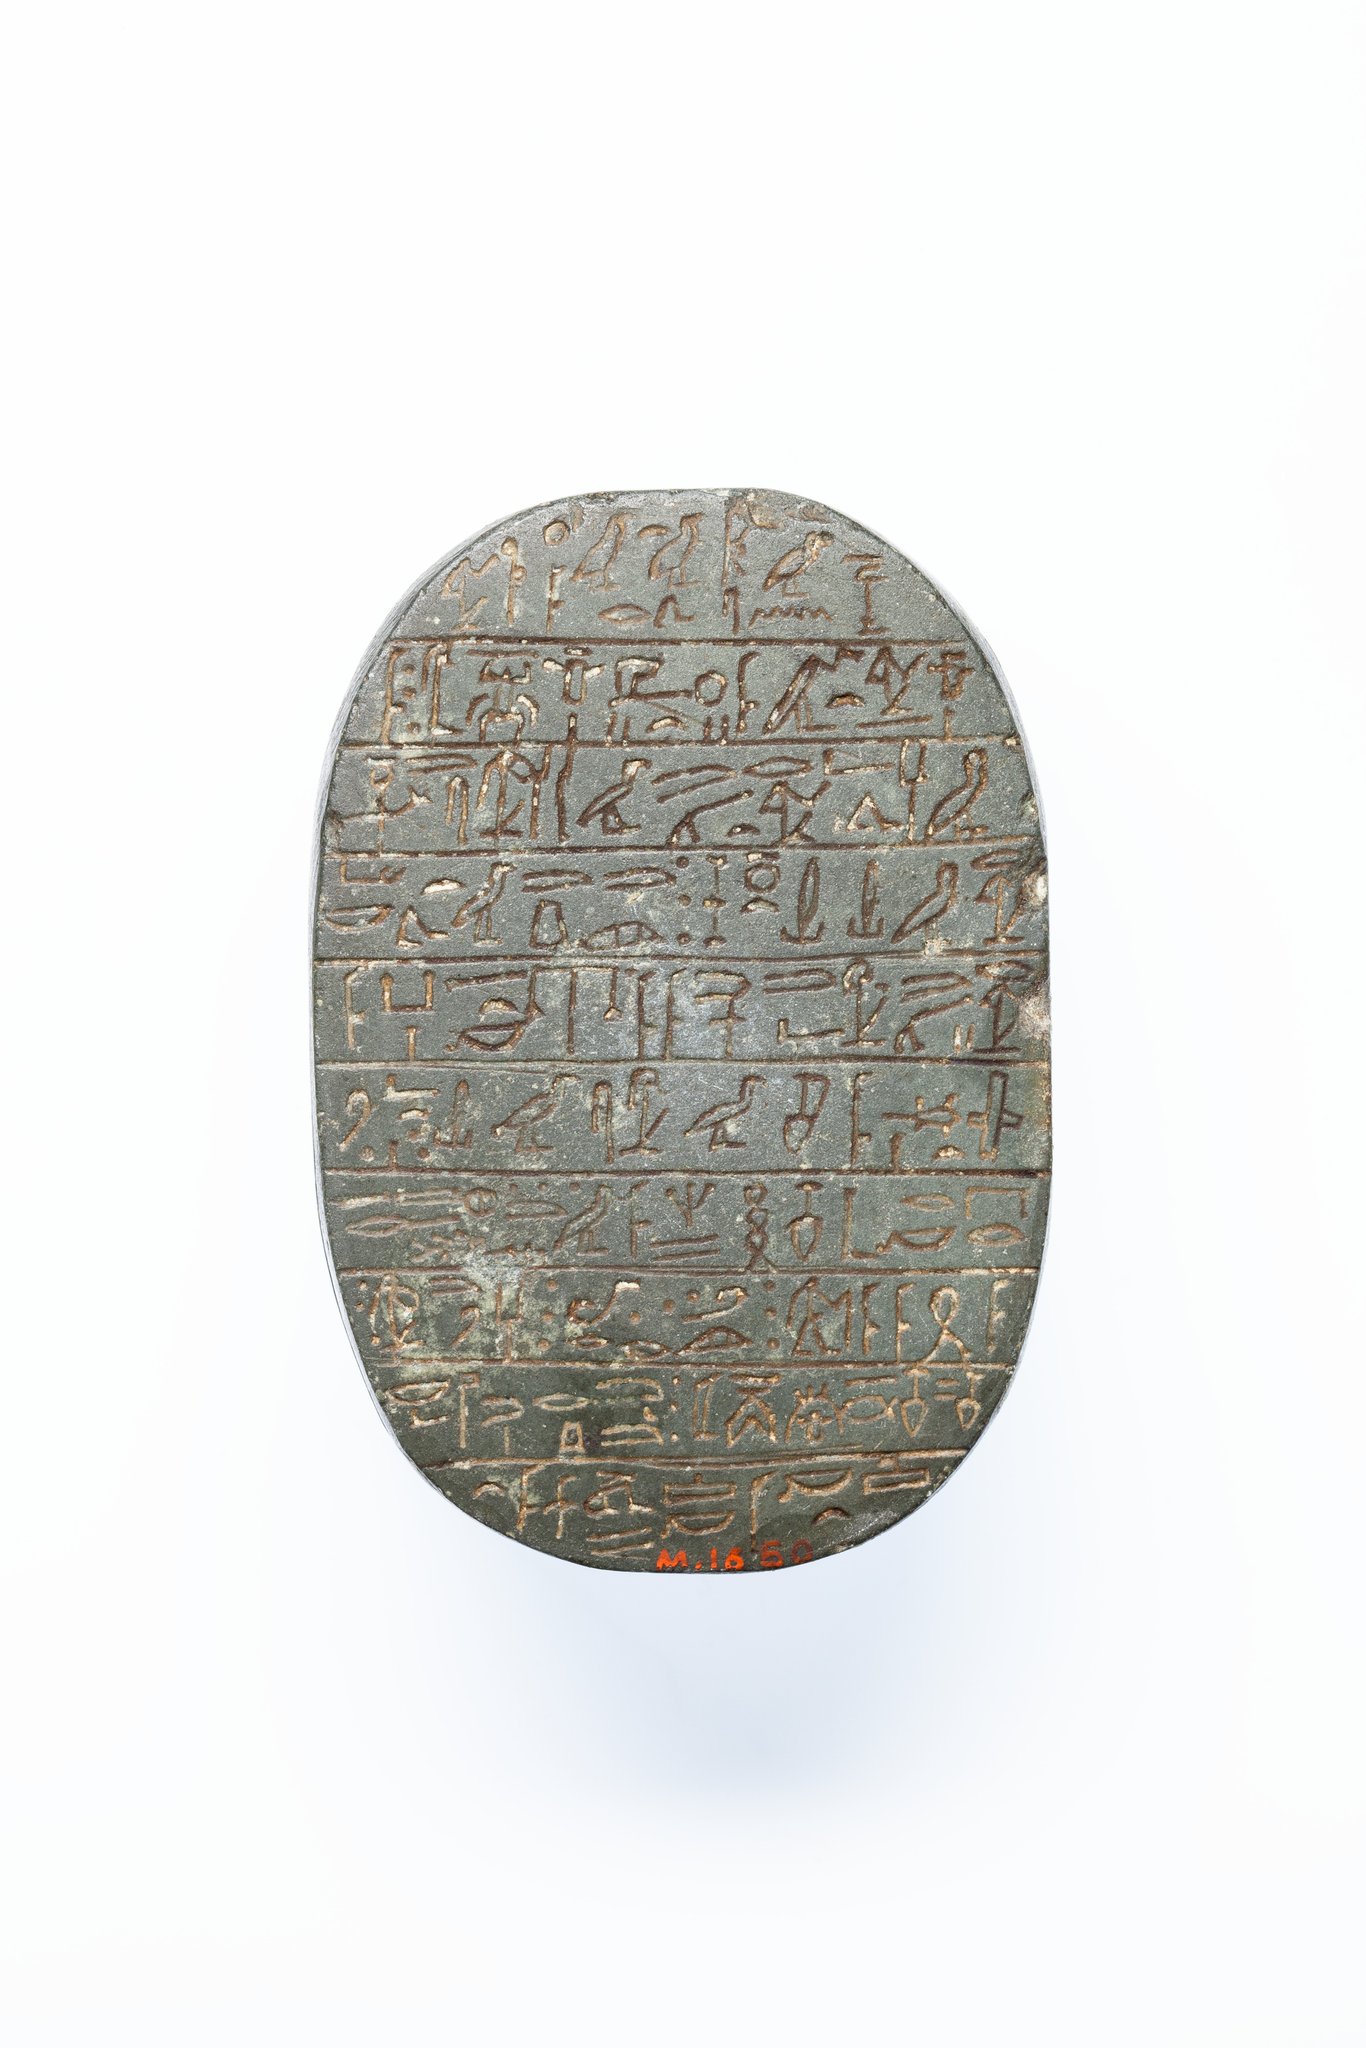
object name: heart scarab, ruy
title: Heart Scarab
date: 664-332 BCE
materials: stone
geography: egypt